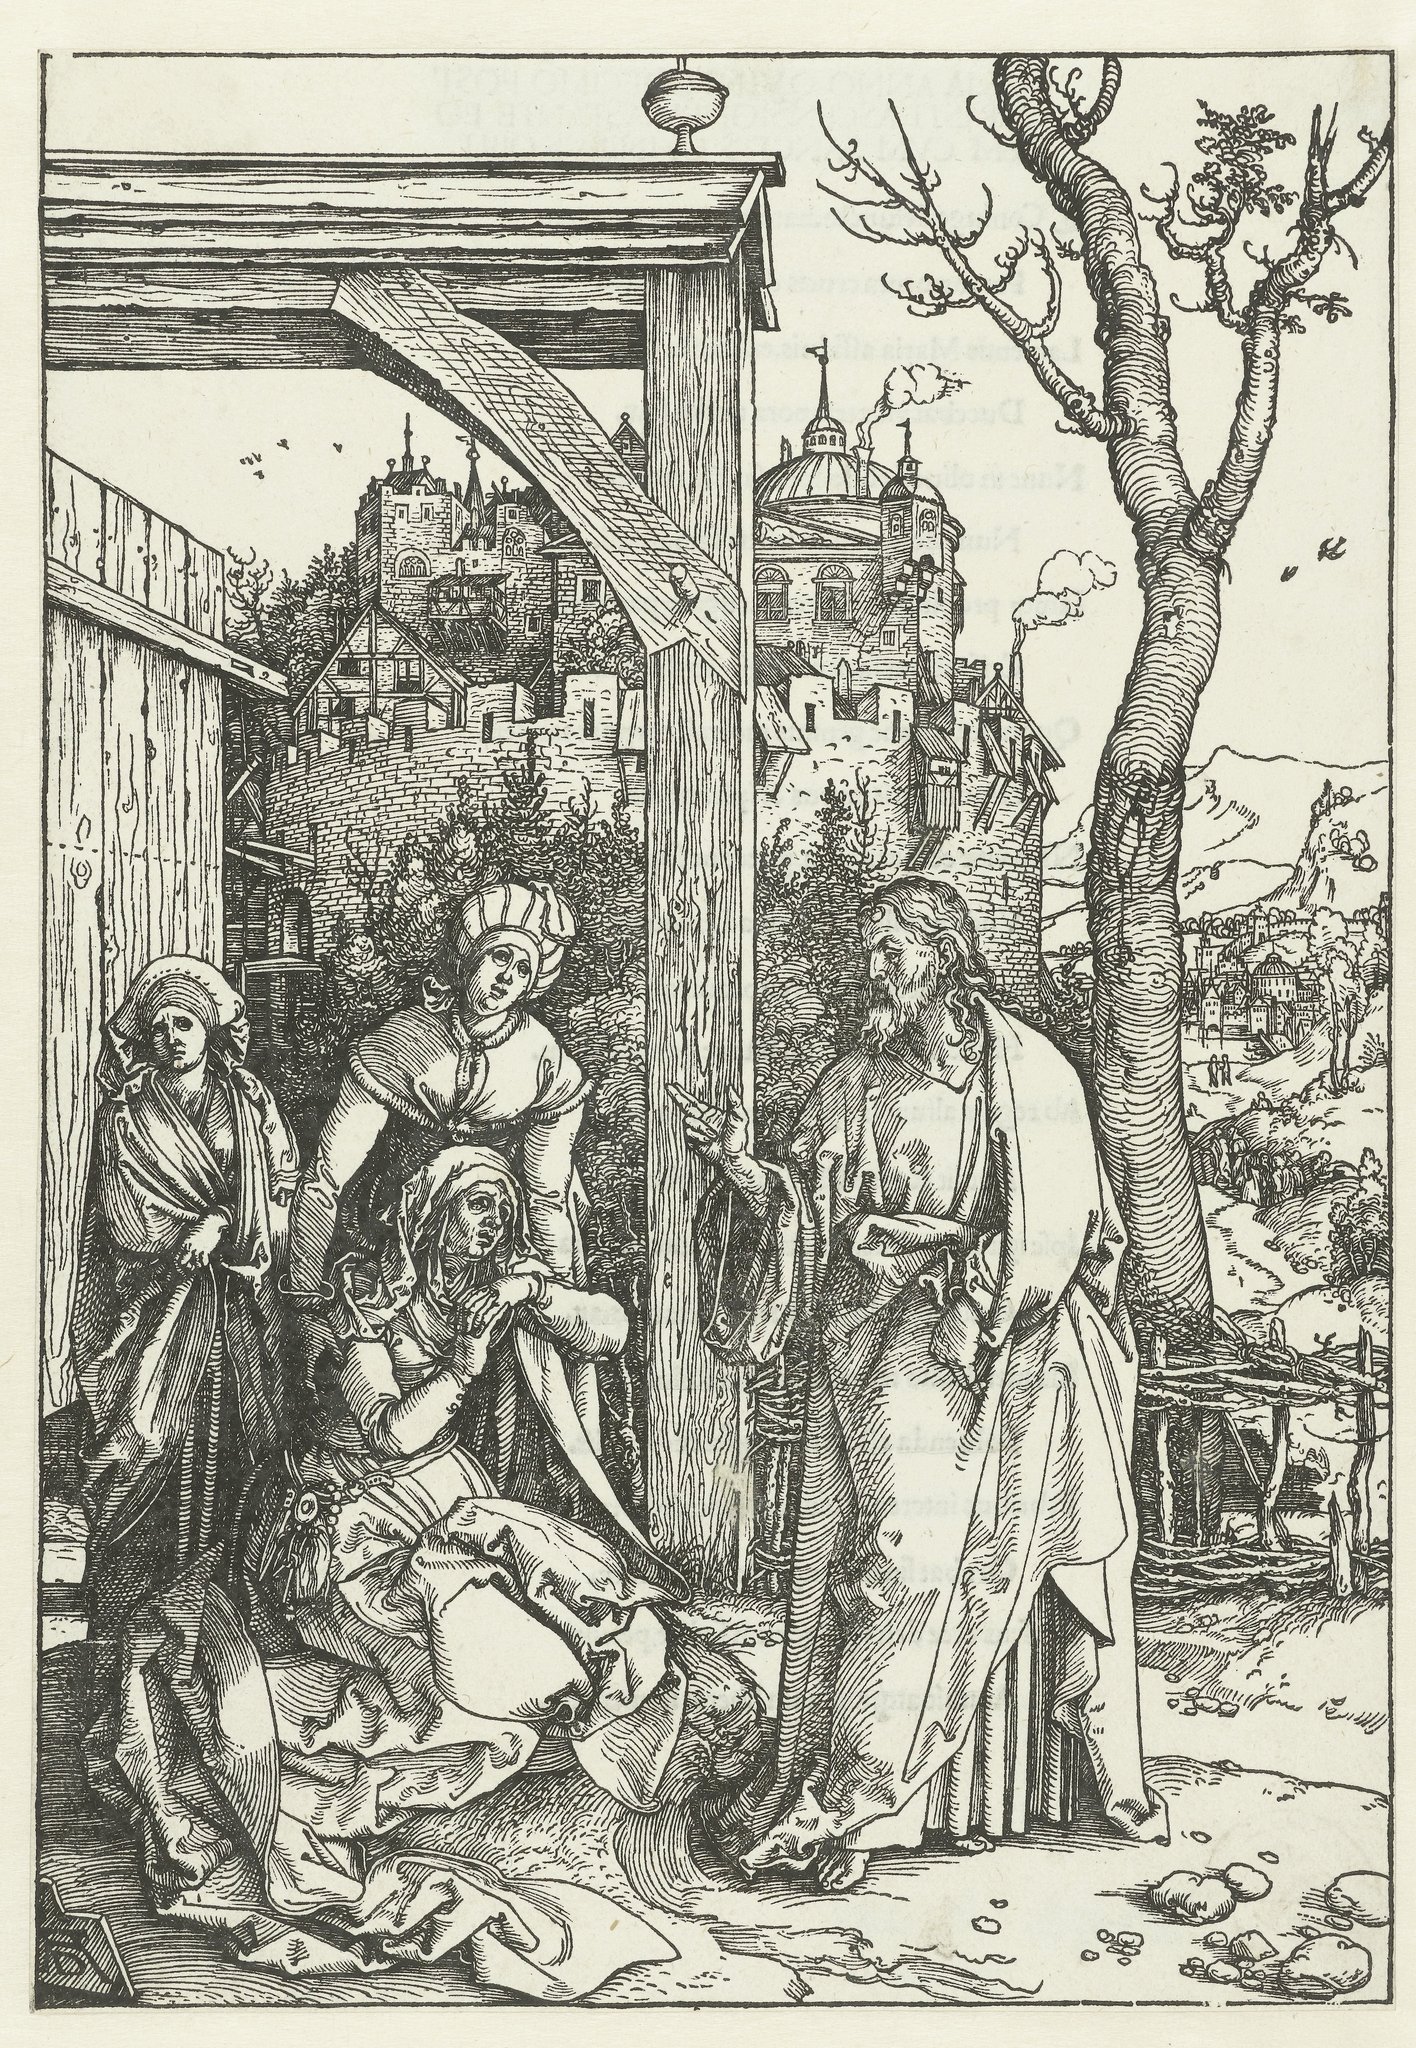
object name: print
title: Christus neemt afscheid van Maria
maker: albrecht dürer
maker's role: draughtsman, painter, print maker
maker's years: 1471-1528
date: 1502-1506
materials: paper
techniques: letterpress printing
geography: nuremberg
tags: christ taking leave of mary, usually mary magdalene present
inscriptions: collector's mark: Lugt 240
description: Maria knielt met van verdriet vertrokken gezicht voor Christus, die afscheid van haar neemt. Twee vrouwen (Martha en Maria Magdalena) staan achter Maria. Op de achtergrond een burcht of stad. Op versozijde gedrukte Latijnse tekst. Deze prent is onderdeel van een serie van 20 prenten, bestaand uit een titelprent en 19 prenten met scènes uit het leven van Maria.